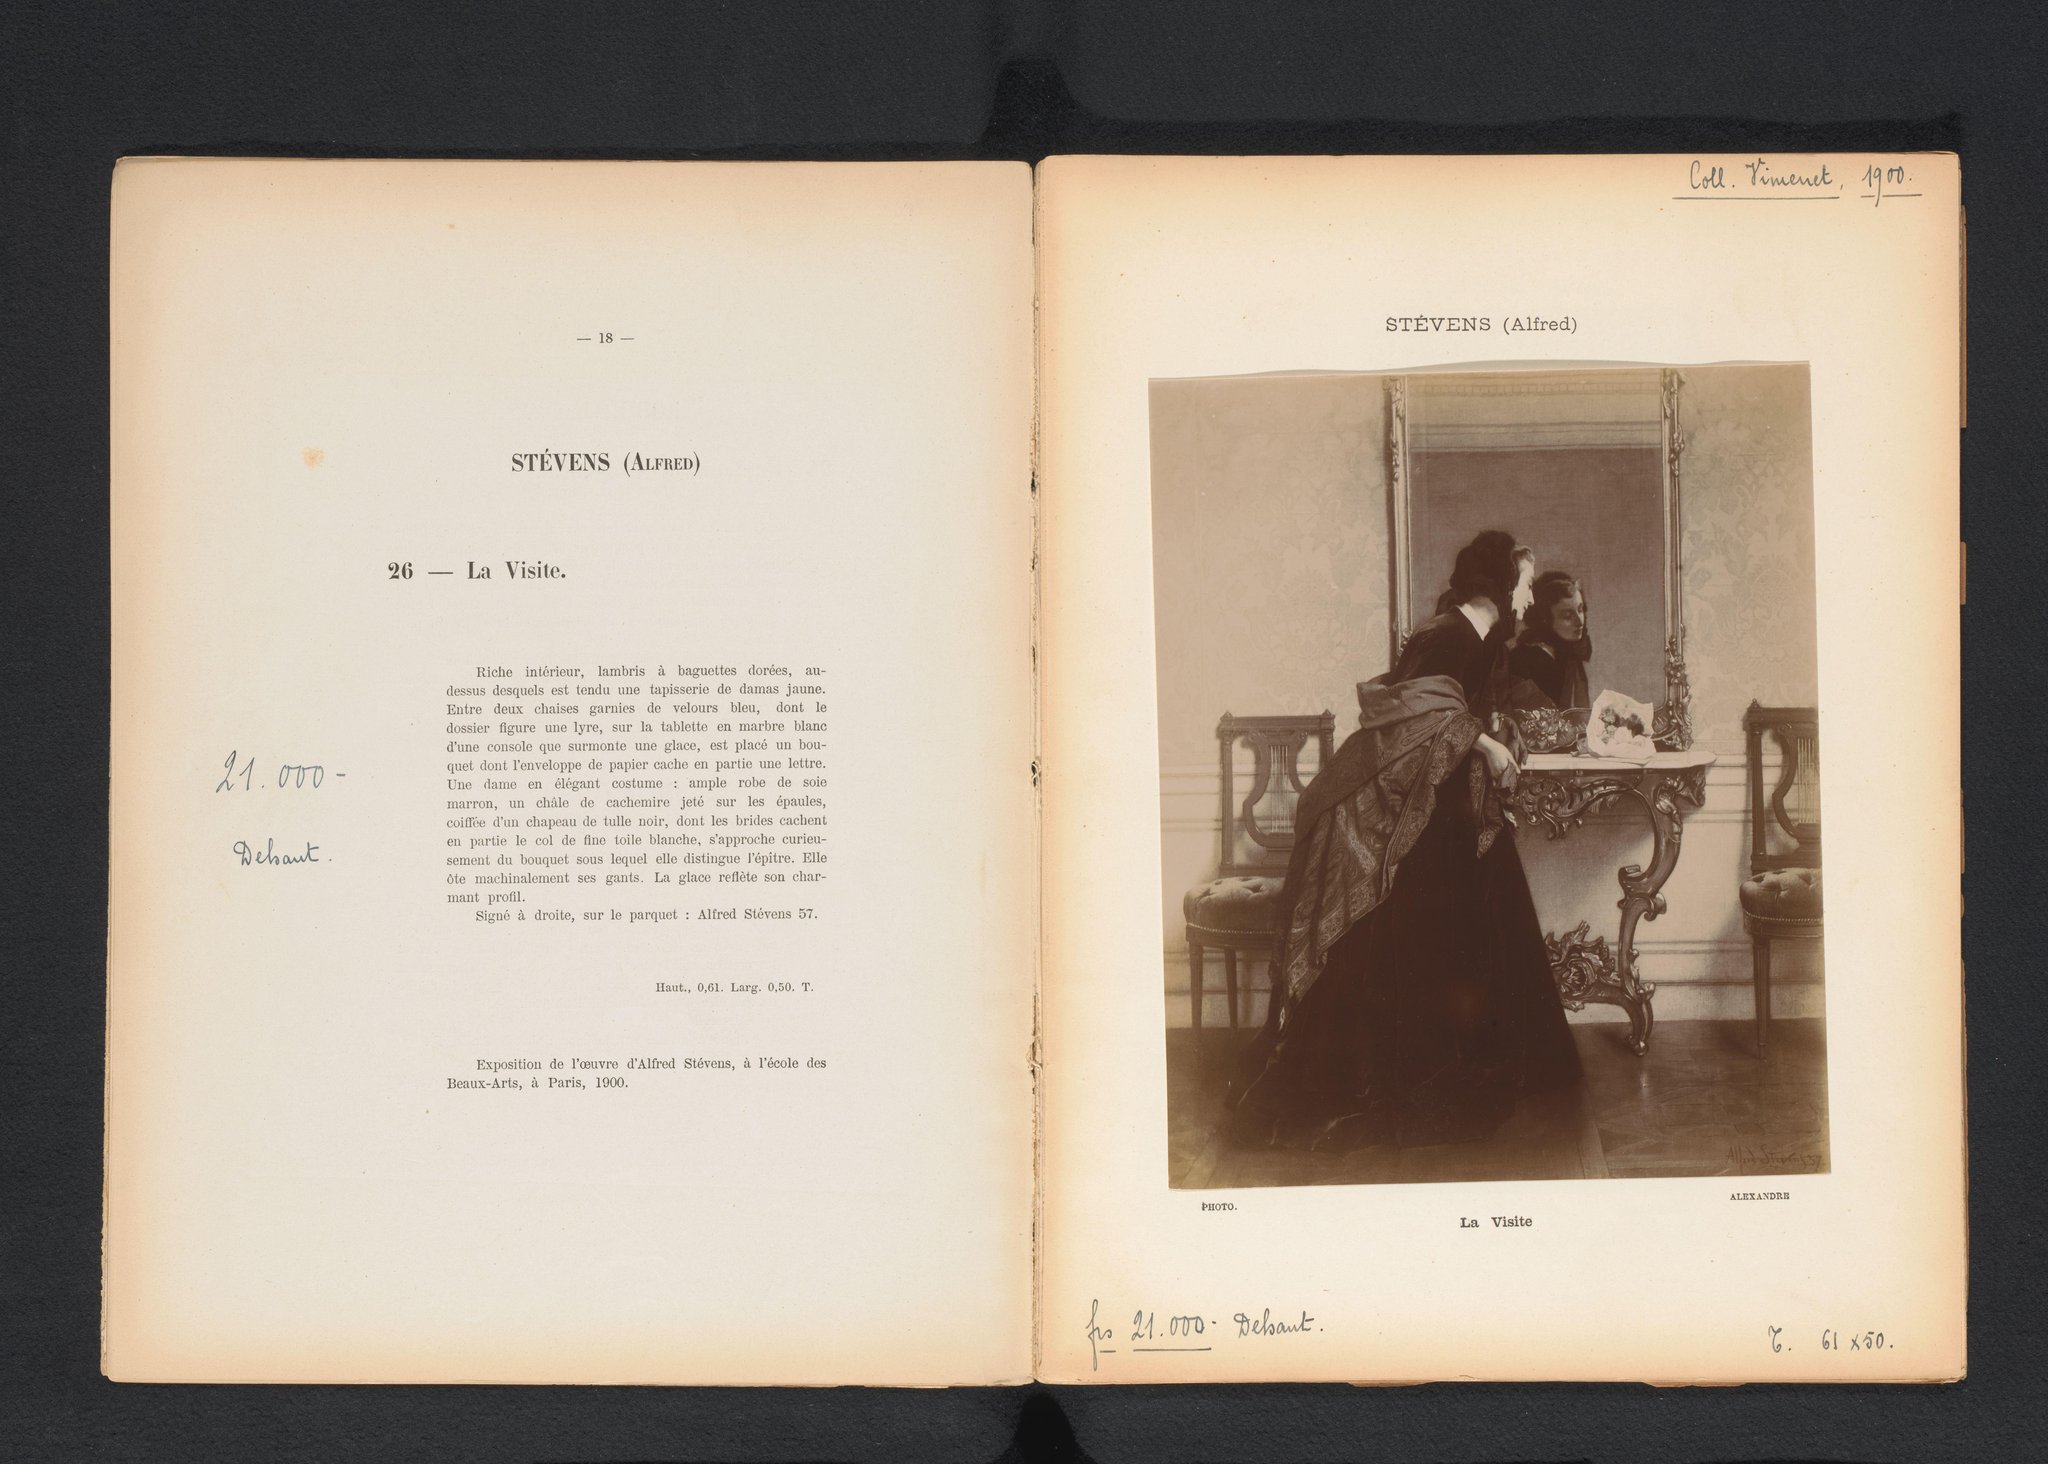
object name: photograph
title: La Visite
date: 1895-1900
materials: photographic support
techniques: gelatin silver print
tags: adult woman, reflection (in a mirror) - aa - (for) women (+ front view)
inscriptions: number: ‘frs. 21.000- Dehaut.’, annotation: ‘Coll. Vimenet, 1900.’, annotation: ‘R. 61 x 50.’